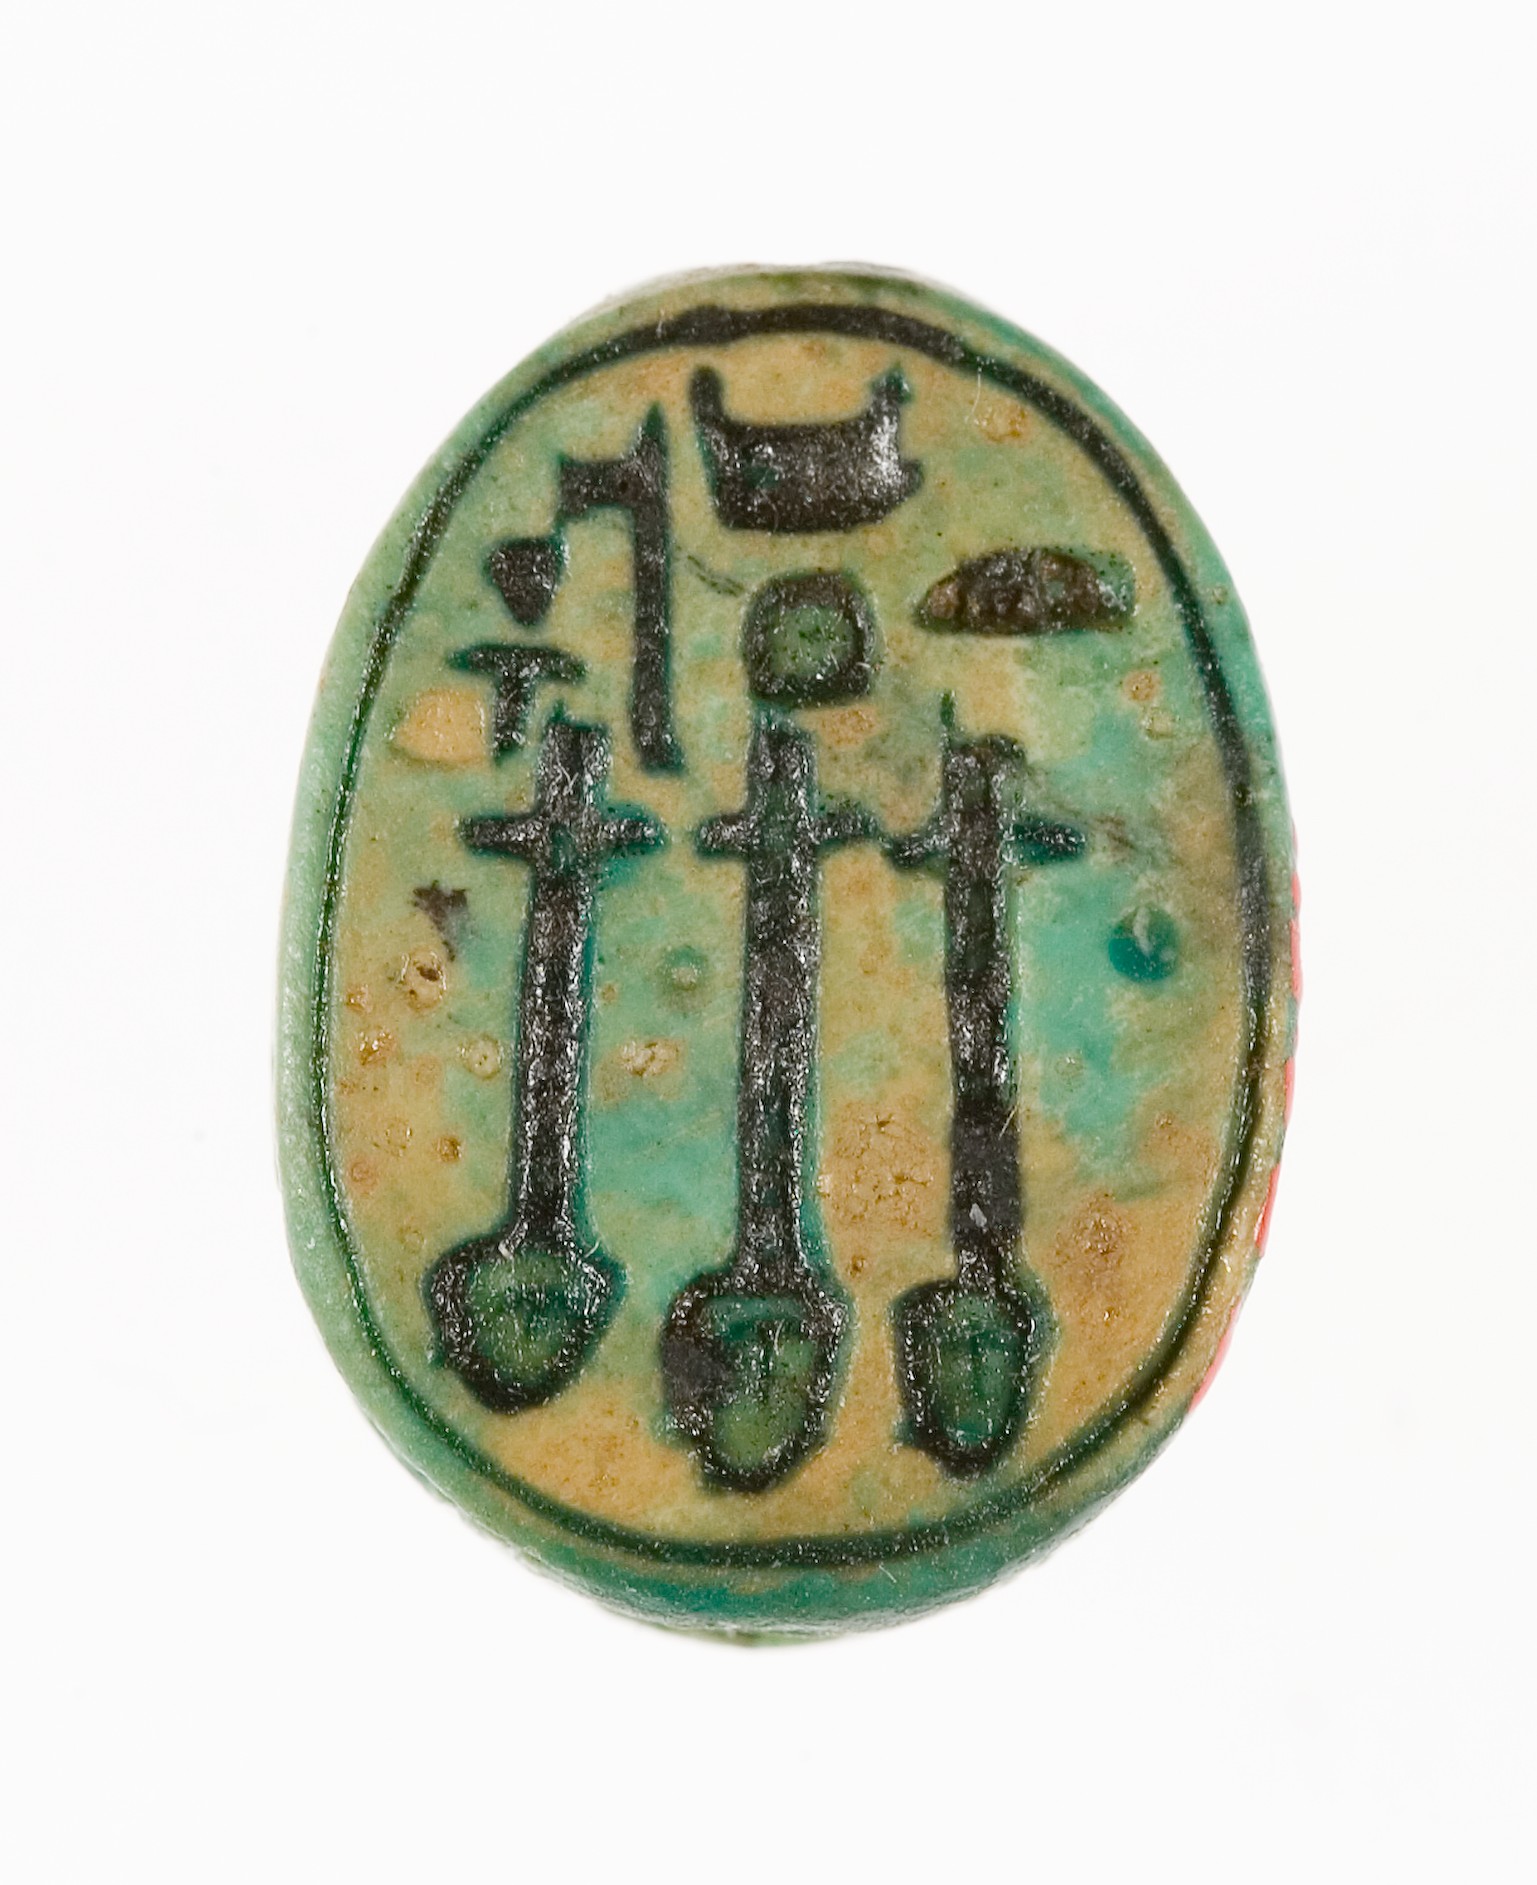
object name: scarab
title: Scarab Inscribed for the God's Wife Neferure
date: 1479-1458 BCE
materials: stone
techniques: glazing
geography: egypt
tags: scarabs